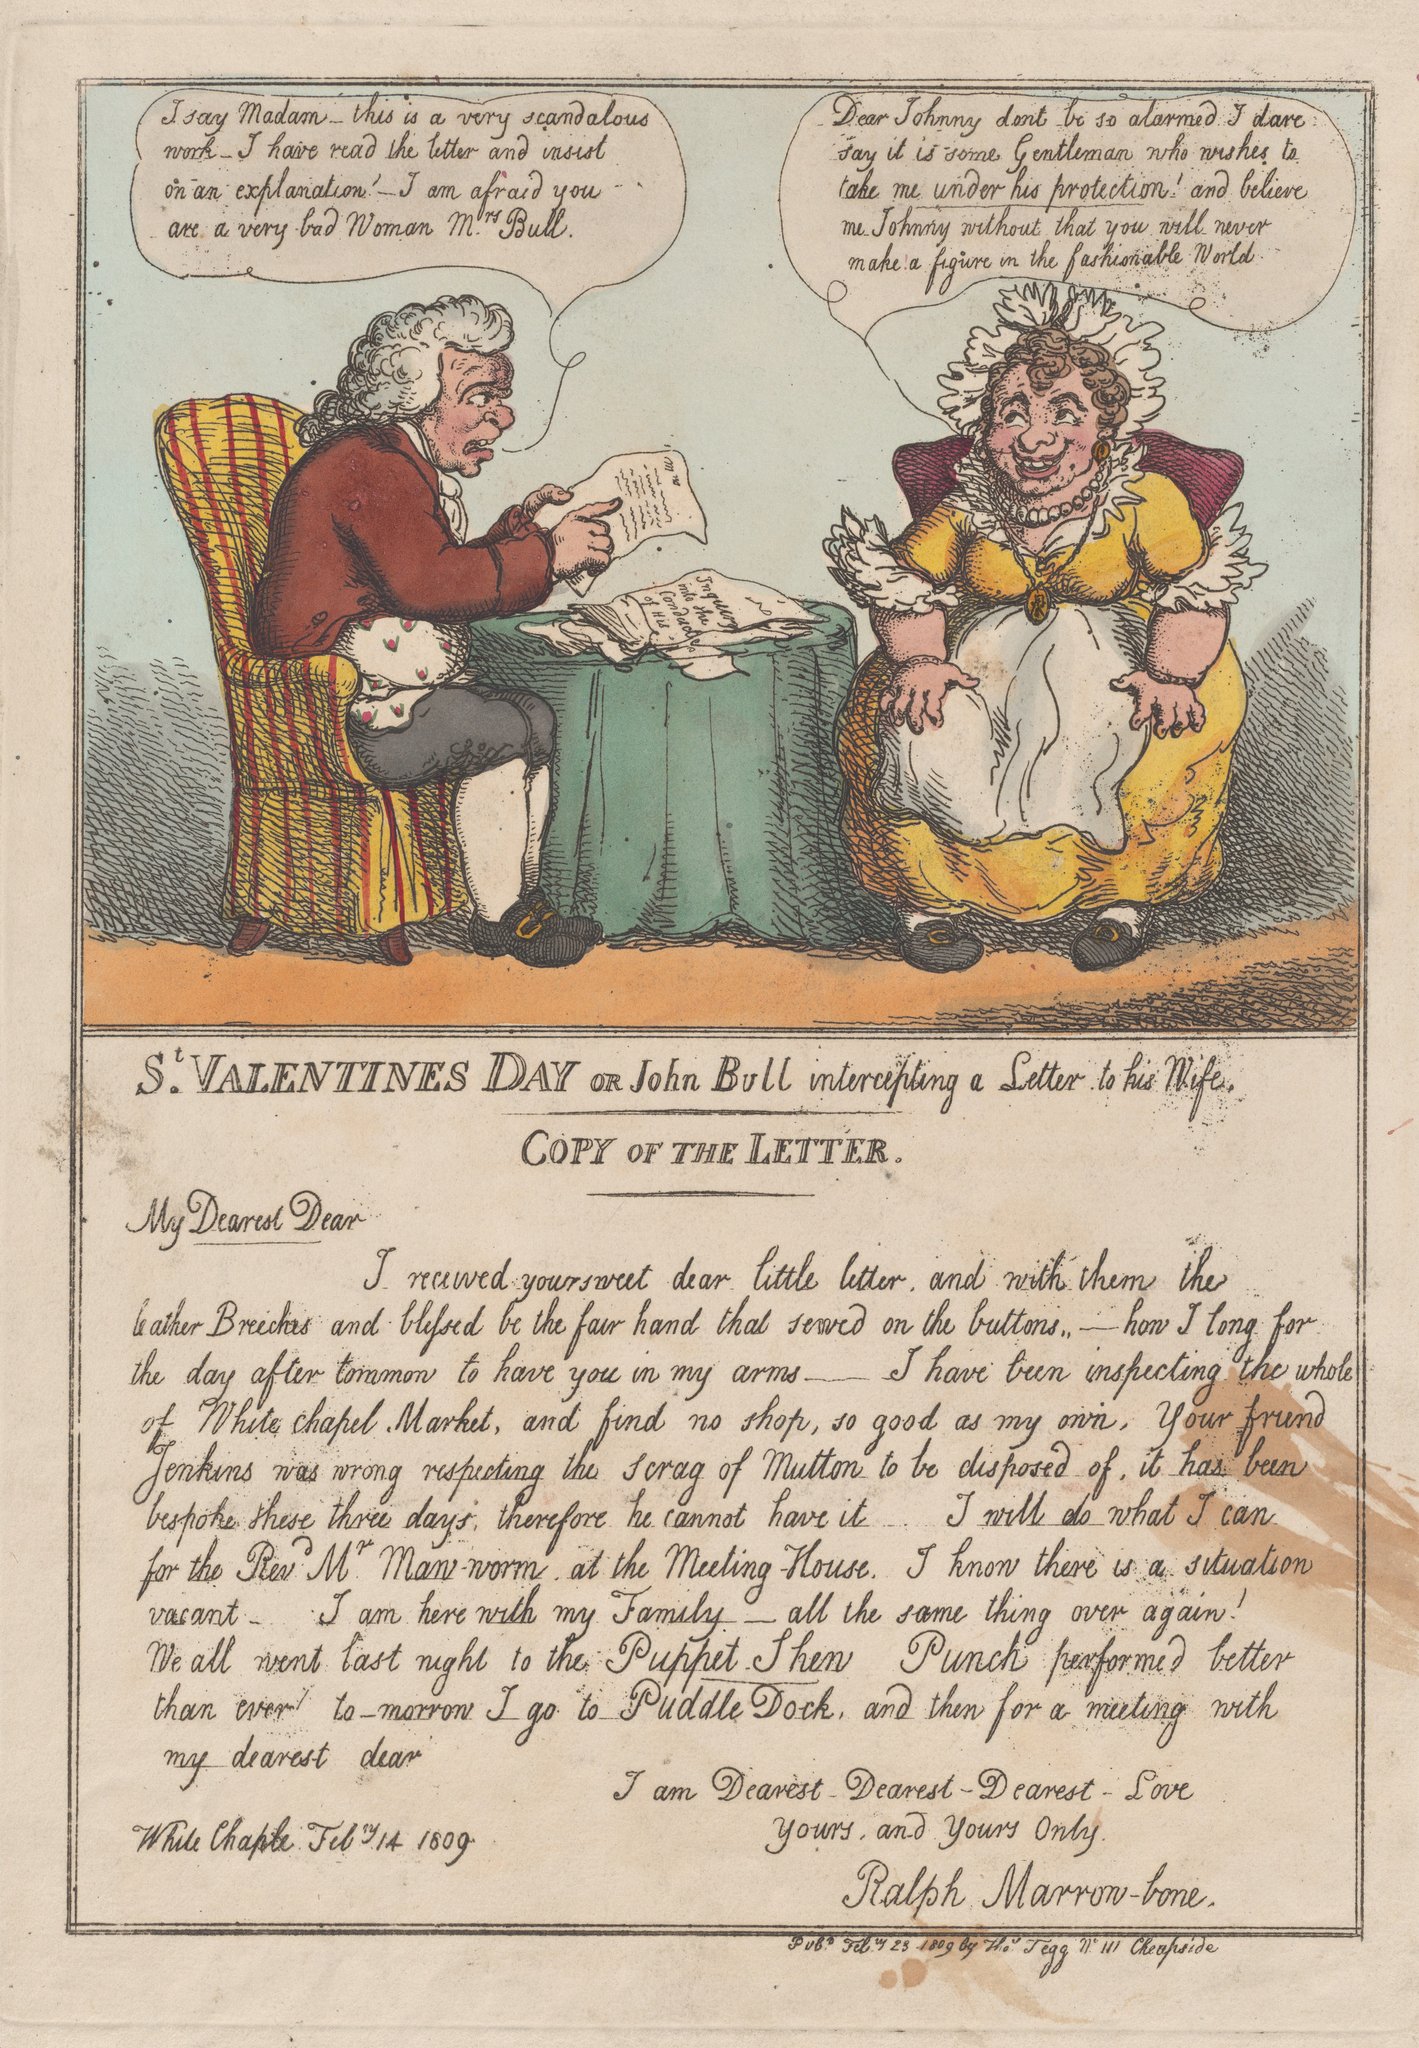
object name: print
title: St. Valentine's Day or John Bull intercepting a Letter to his Wife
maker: thomas rowlandson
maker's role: artist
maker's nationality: british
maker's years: 1757-1827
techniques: etching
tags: satire,men,women,politics